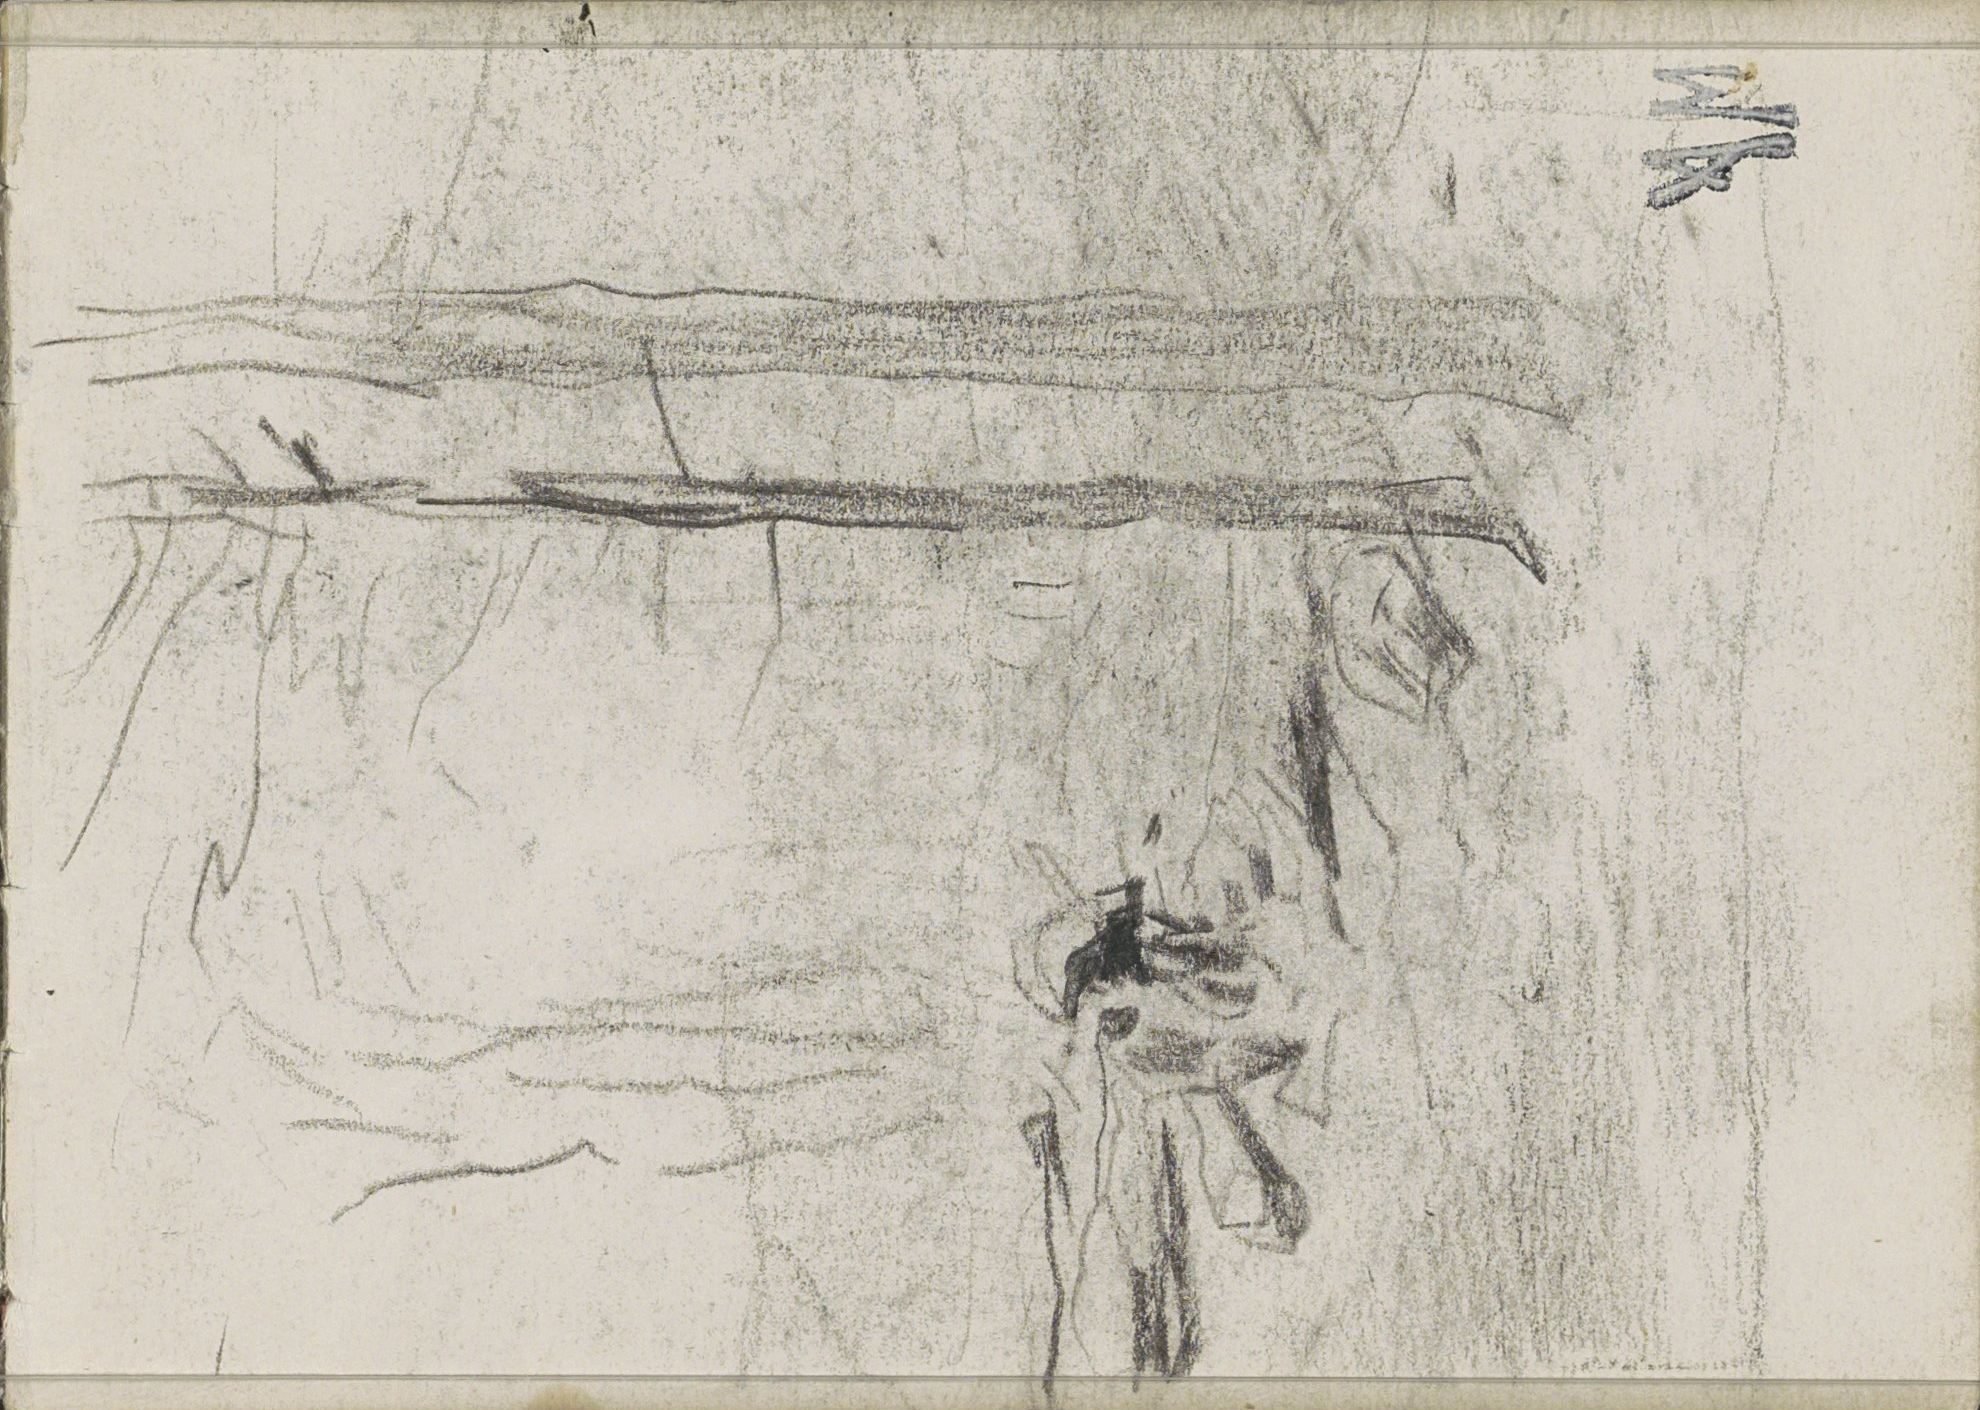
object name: sketchbook leaf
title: Stukken van omgehakte boomstammen op een open plek in een bos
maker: anton mauve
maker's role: draughtsman, painter, print maker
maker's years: 1838-1888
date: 1848-1888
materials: chalk, paper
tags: trees (+ stem, trunk), forest, wood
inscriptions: monogram: ‘AM.’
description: Blad 15 recto uit een schetsboek met 31 bladen.